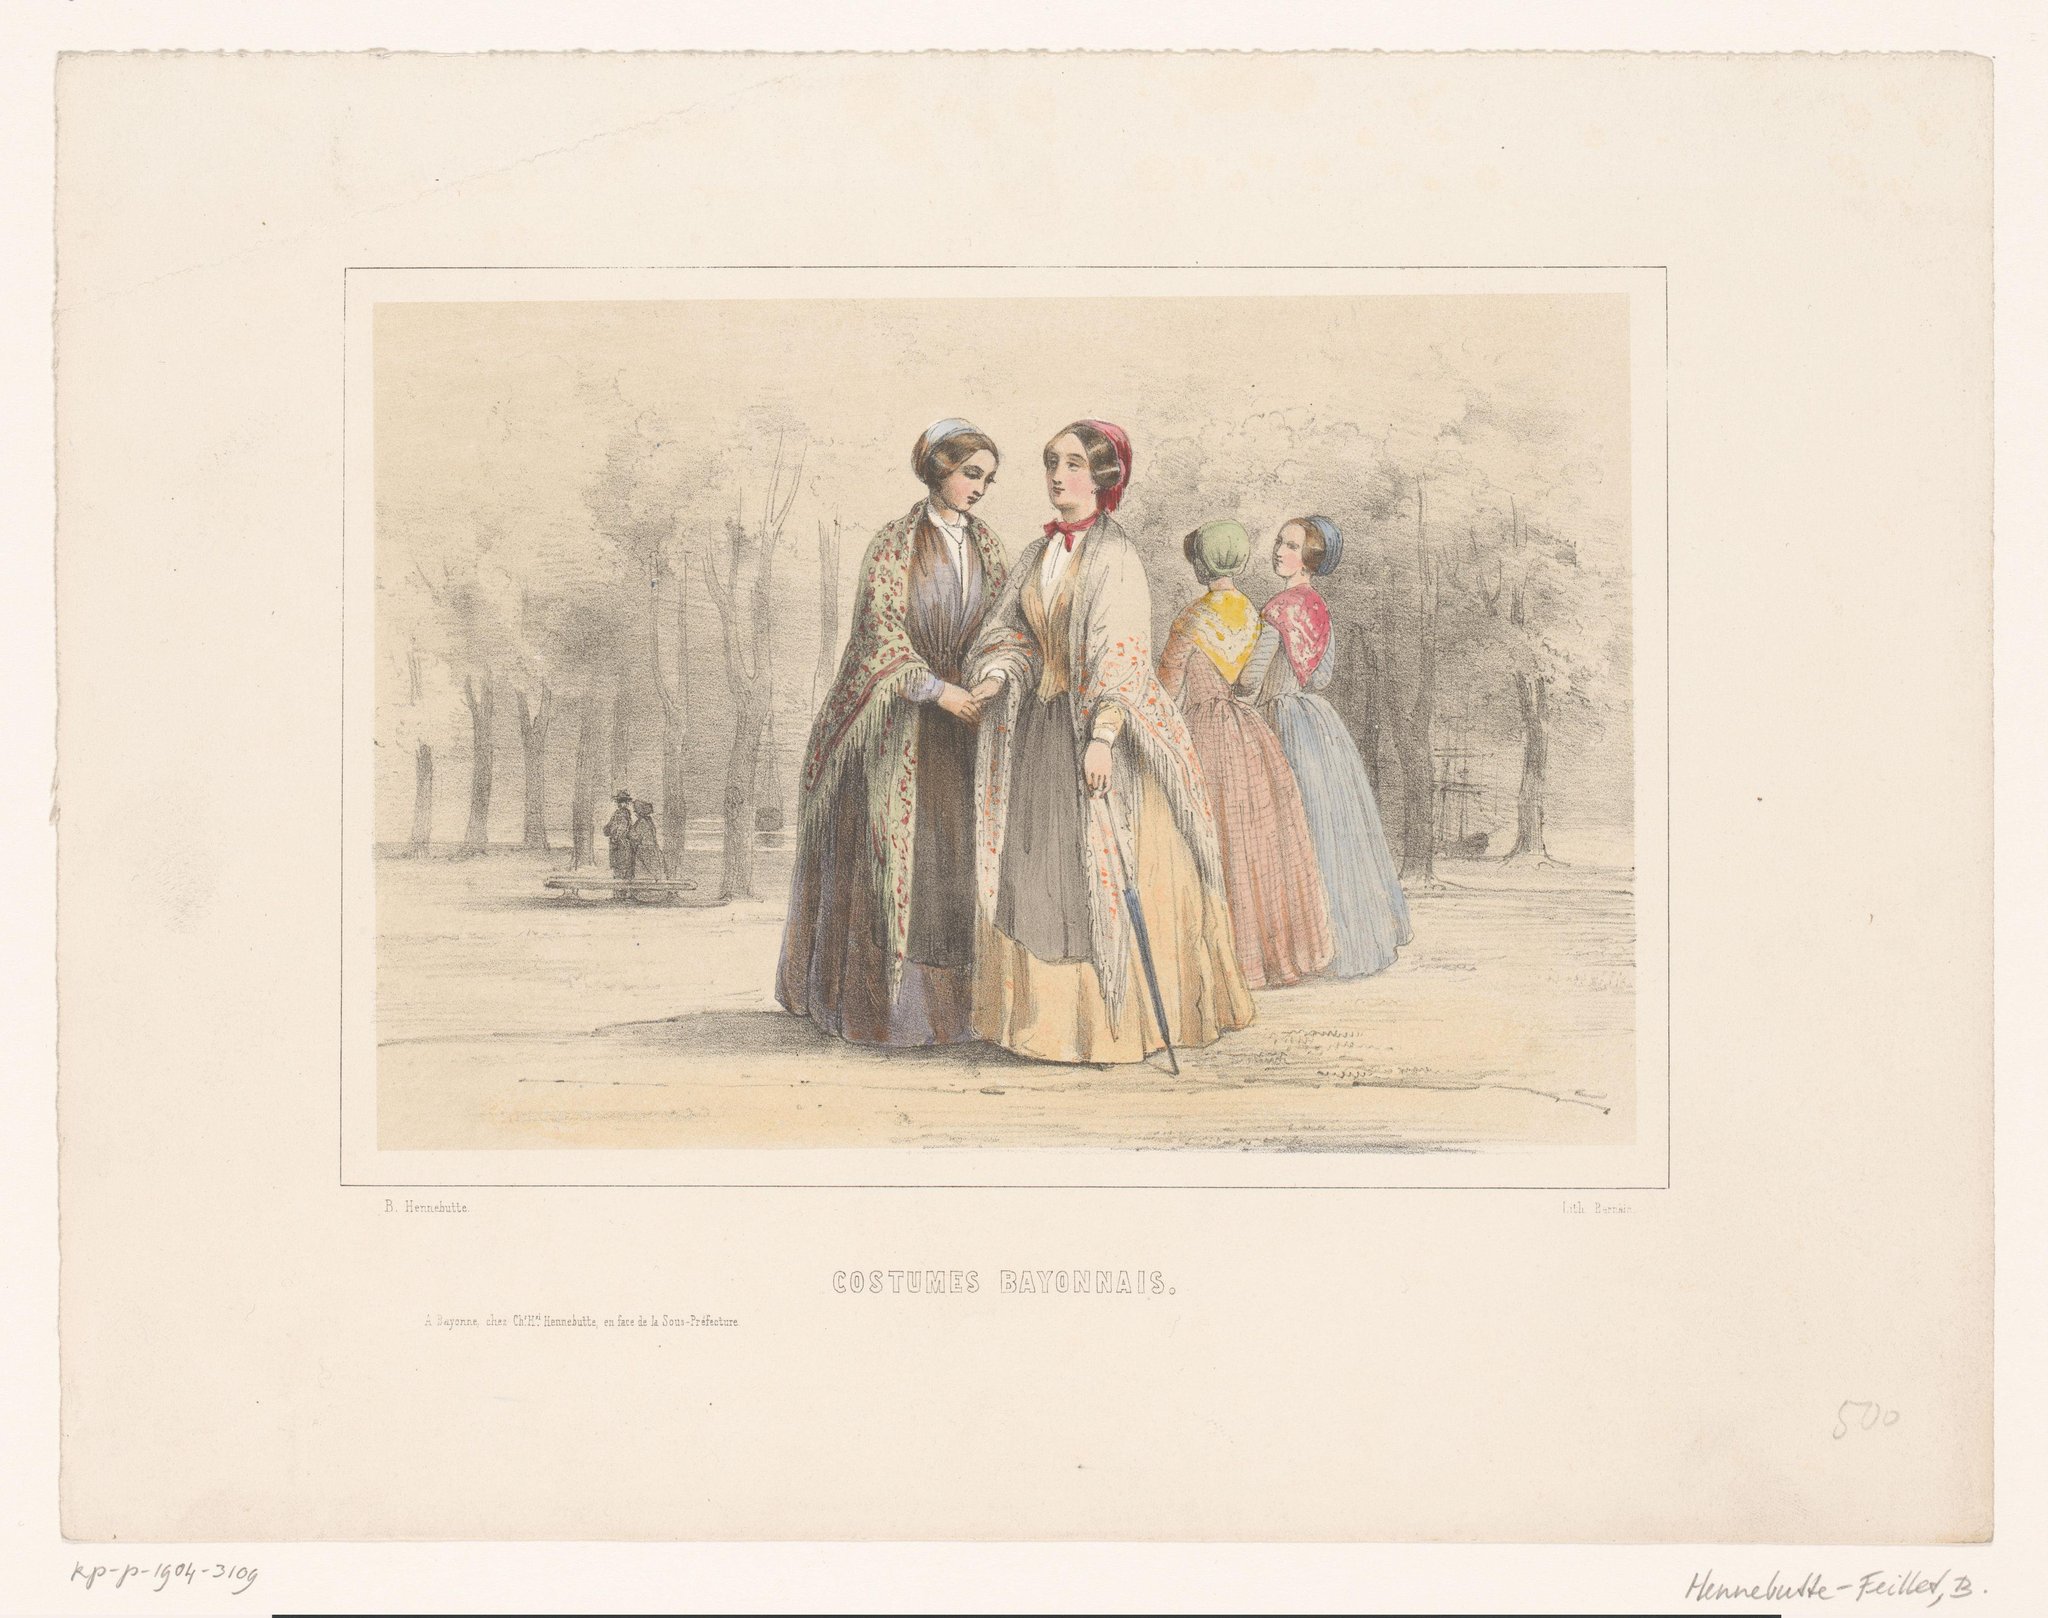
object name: print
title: Costumes Bayonnais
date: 1846-1860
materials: paper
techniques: hand coloring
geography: bayonne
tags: folk costume, regional costume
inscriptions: collector's mark: Lugt 2228a